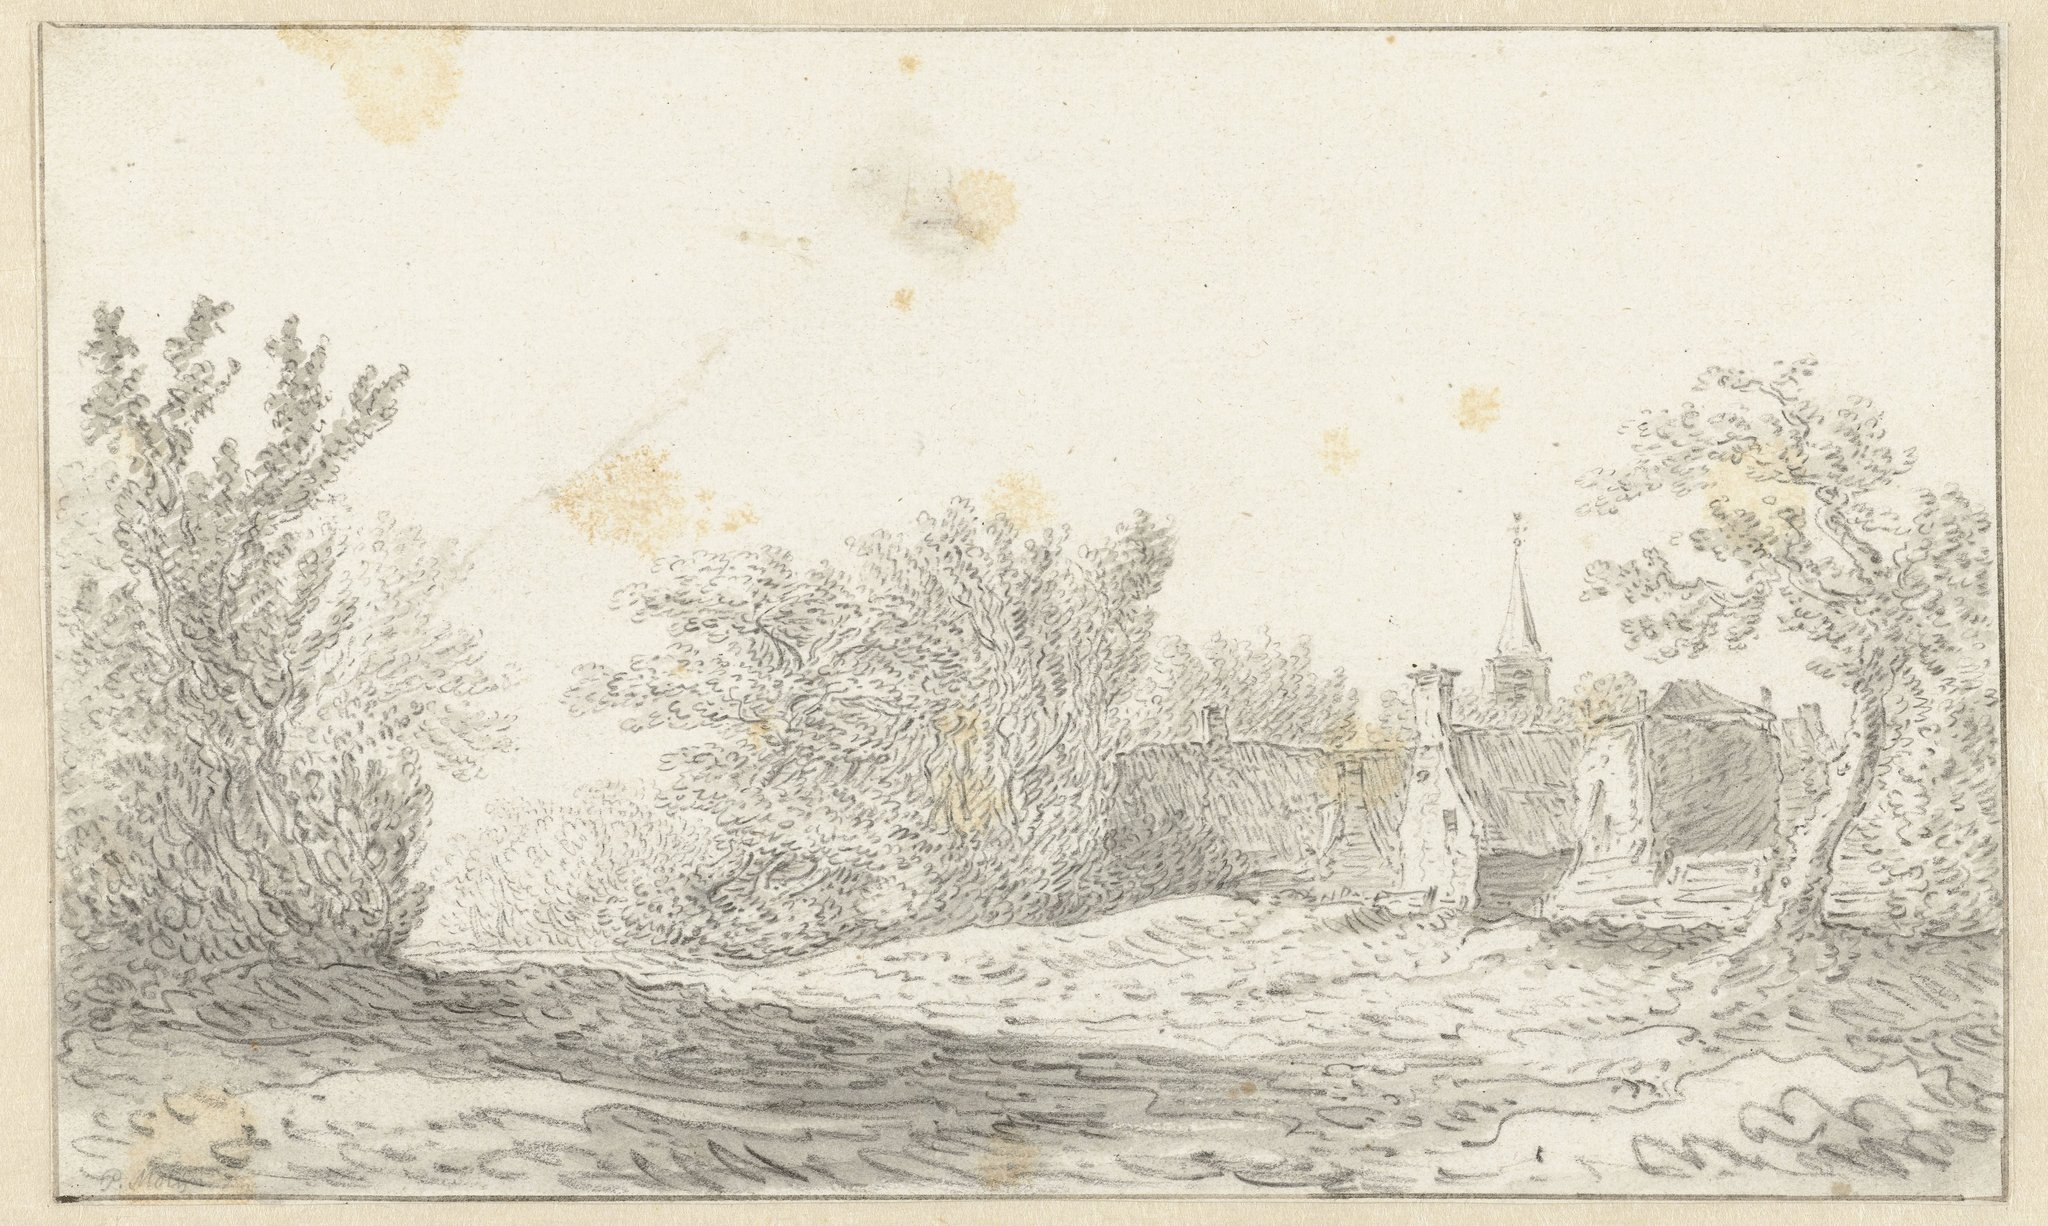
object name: drawing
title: Landschap met enkele huizen en kerktoren van een dorp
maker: salomon van ruysdael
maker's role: draughtsman, painter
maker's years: 1600-1670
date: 1610-1670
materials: chalk, paper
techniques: brush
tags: prospect of village, silhouette of village